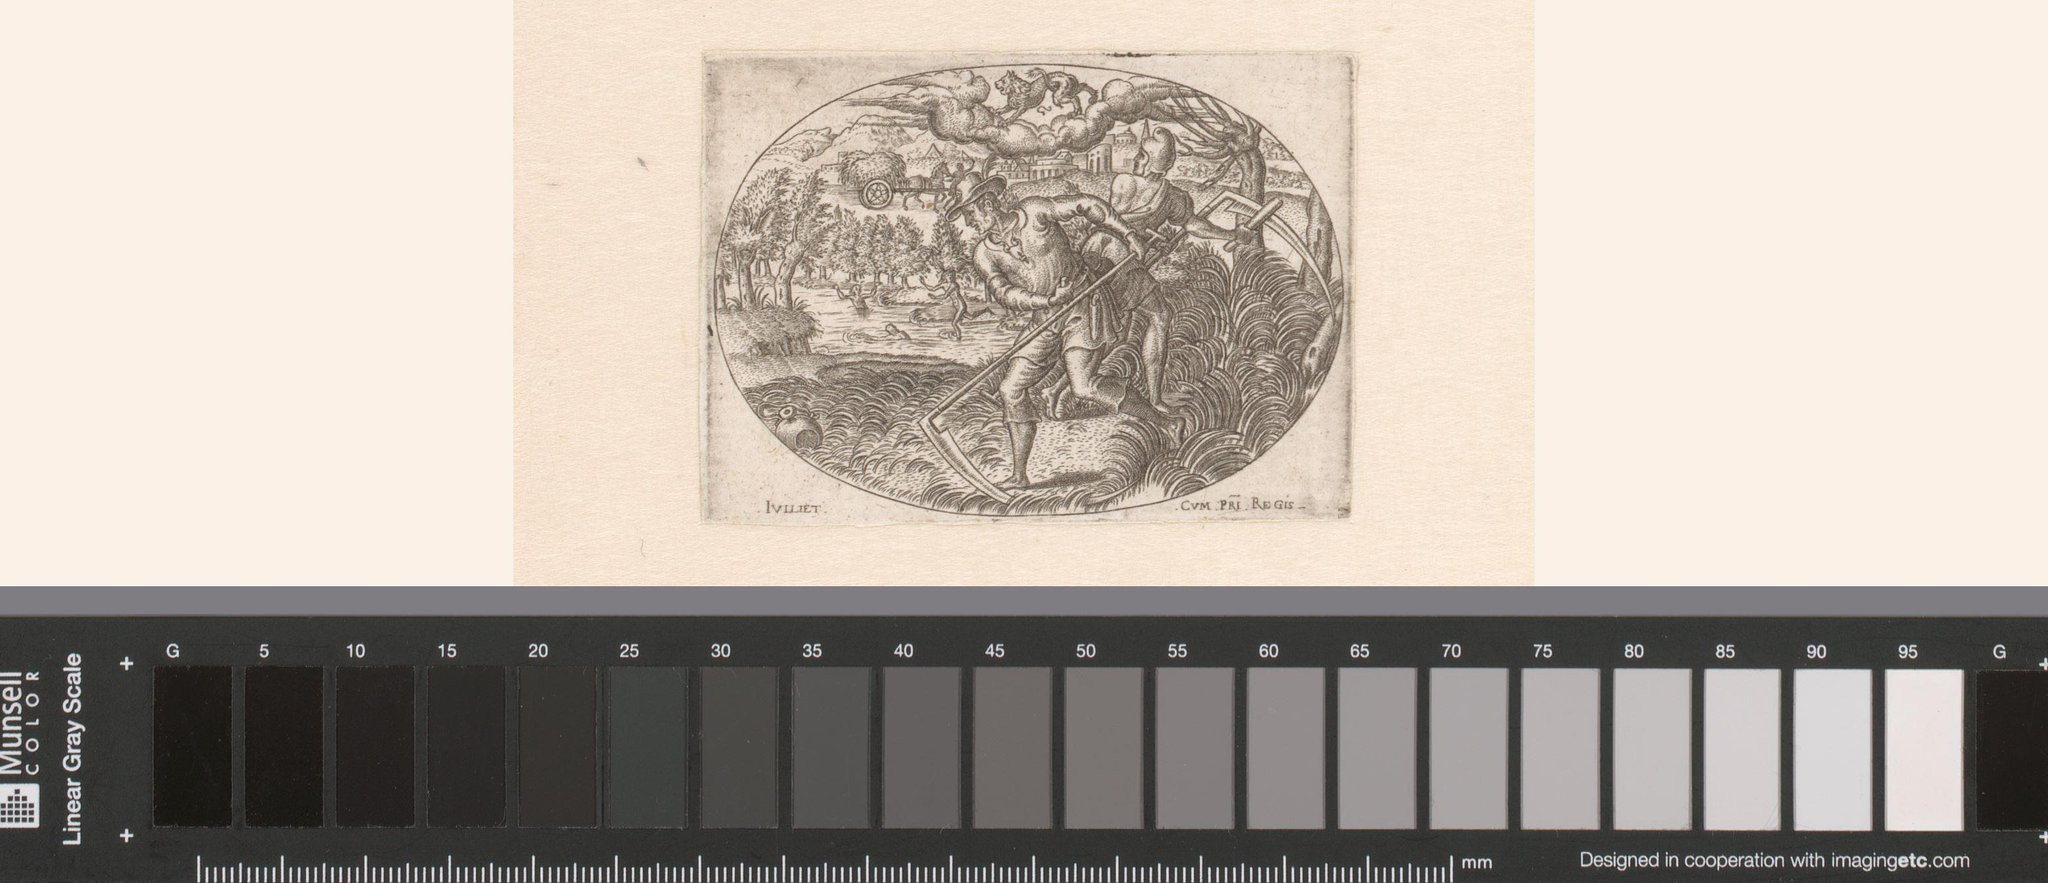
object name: print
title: Twaalf maanden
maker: etienne delaune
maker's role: draughtsman, goldsmith, print maker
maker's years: 1519-1583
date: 1568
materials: paper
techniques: engraving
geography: france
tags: july and its 'labours', leo (zodiacal sign of july)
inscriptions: collector's mark: Lugt 240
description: Maakt deel uit van een twaalfdelige serie van de twaalf maanden met tekens van de dierenriem, in ovale vorm. In de collectie van het Rijksmuseum bevindt zich de complete serie.